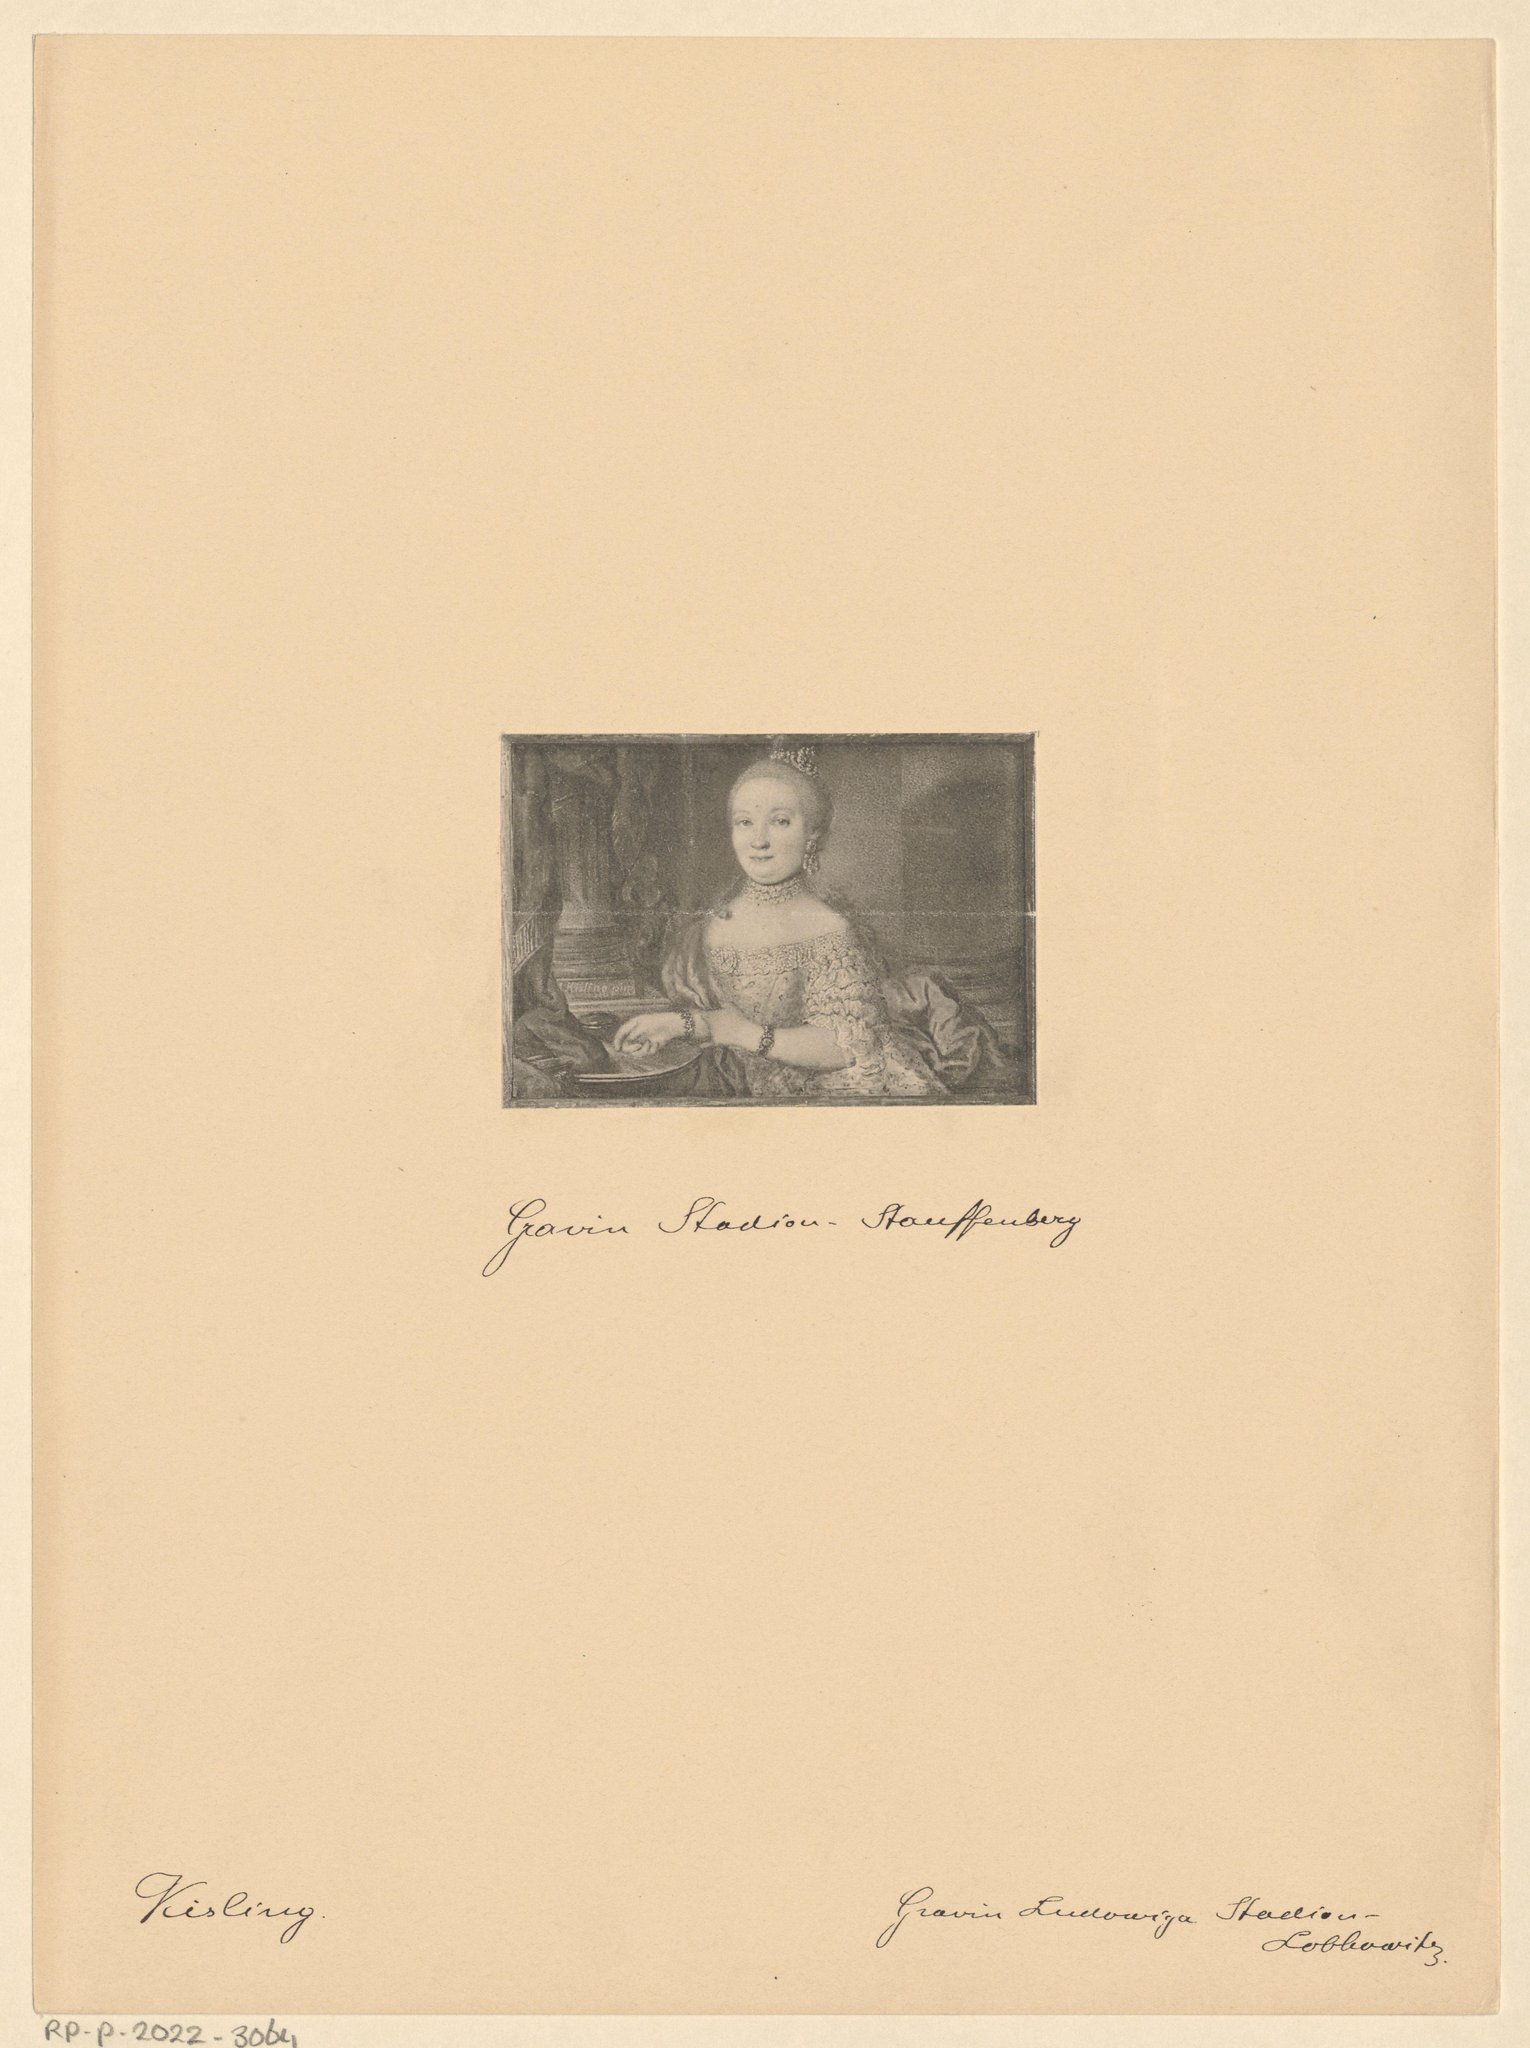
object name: photomechanical print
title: Portret van een onbekende vrouw, mogelijk Ludwiga Stadion-Stauffenberg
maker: Anonymous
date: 1875-1930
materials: paper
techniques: photograph, snipping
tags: historical persons - bb - woman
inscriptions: inscription: ‘Gravin Stadion-Stauffenberg (...) Ludwiga Stadion-/ Lobkowitz’